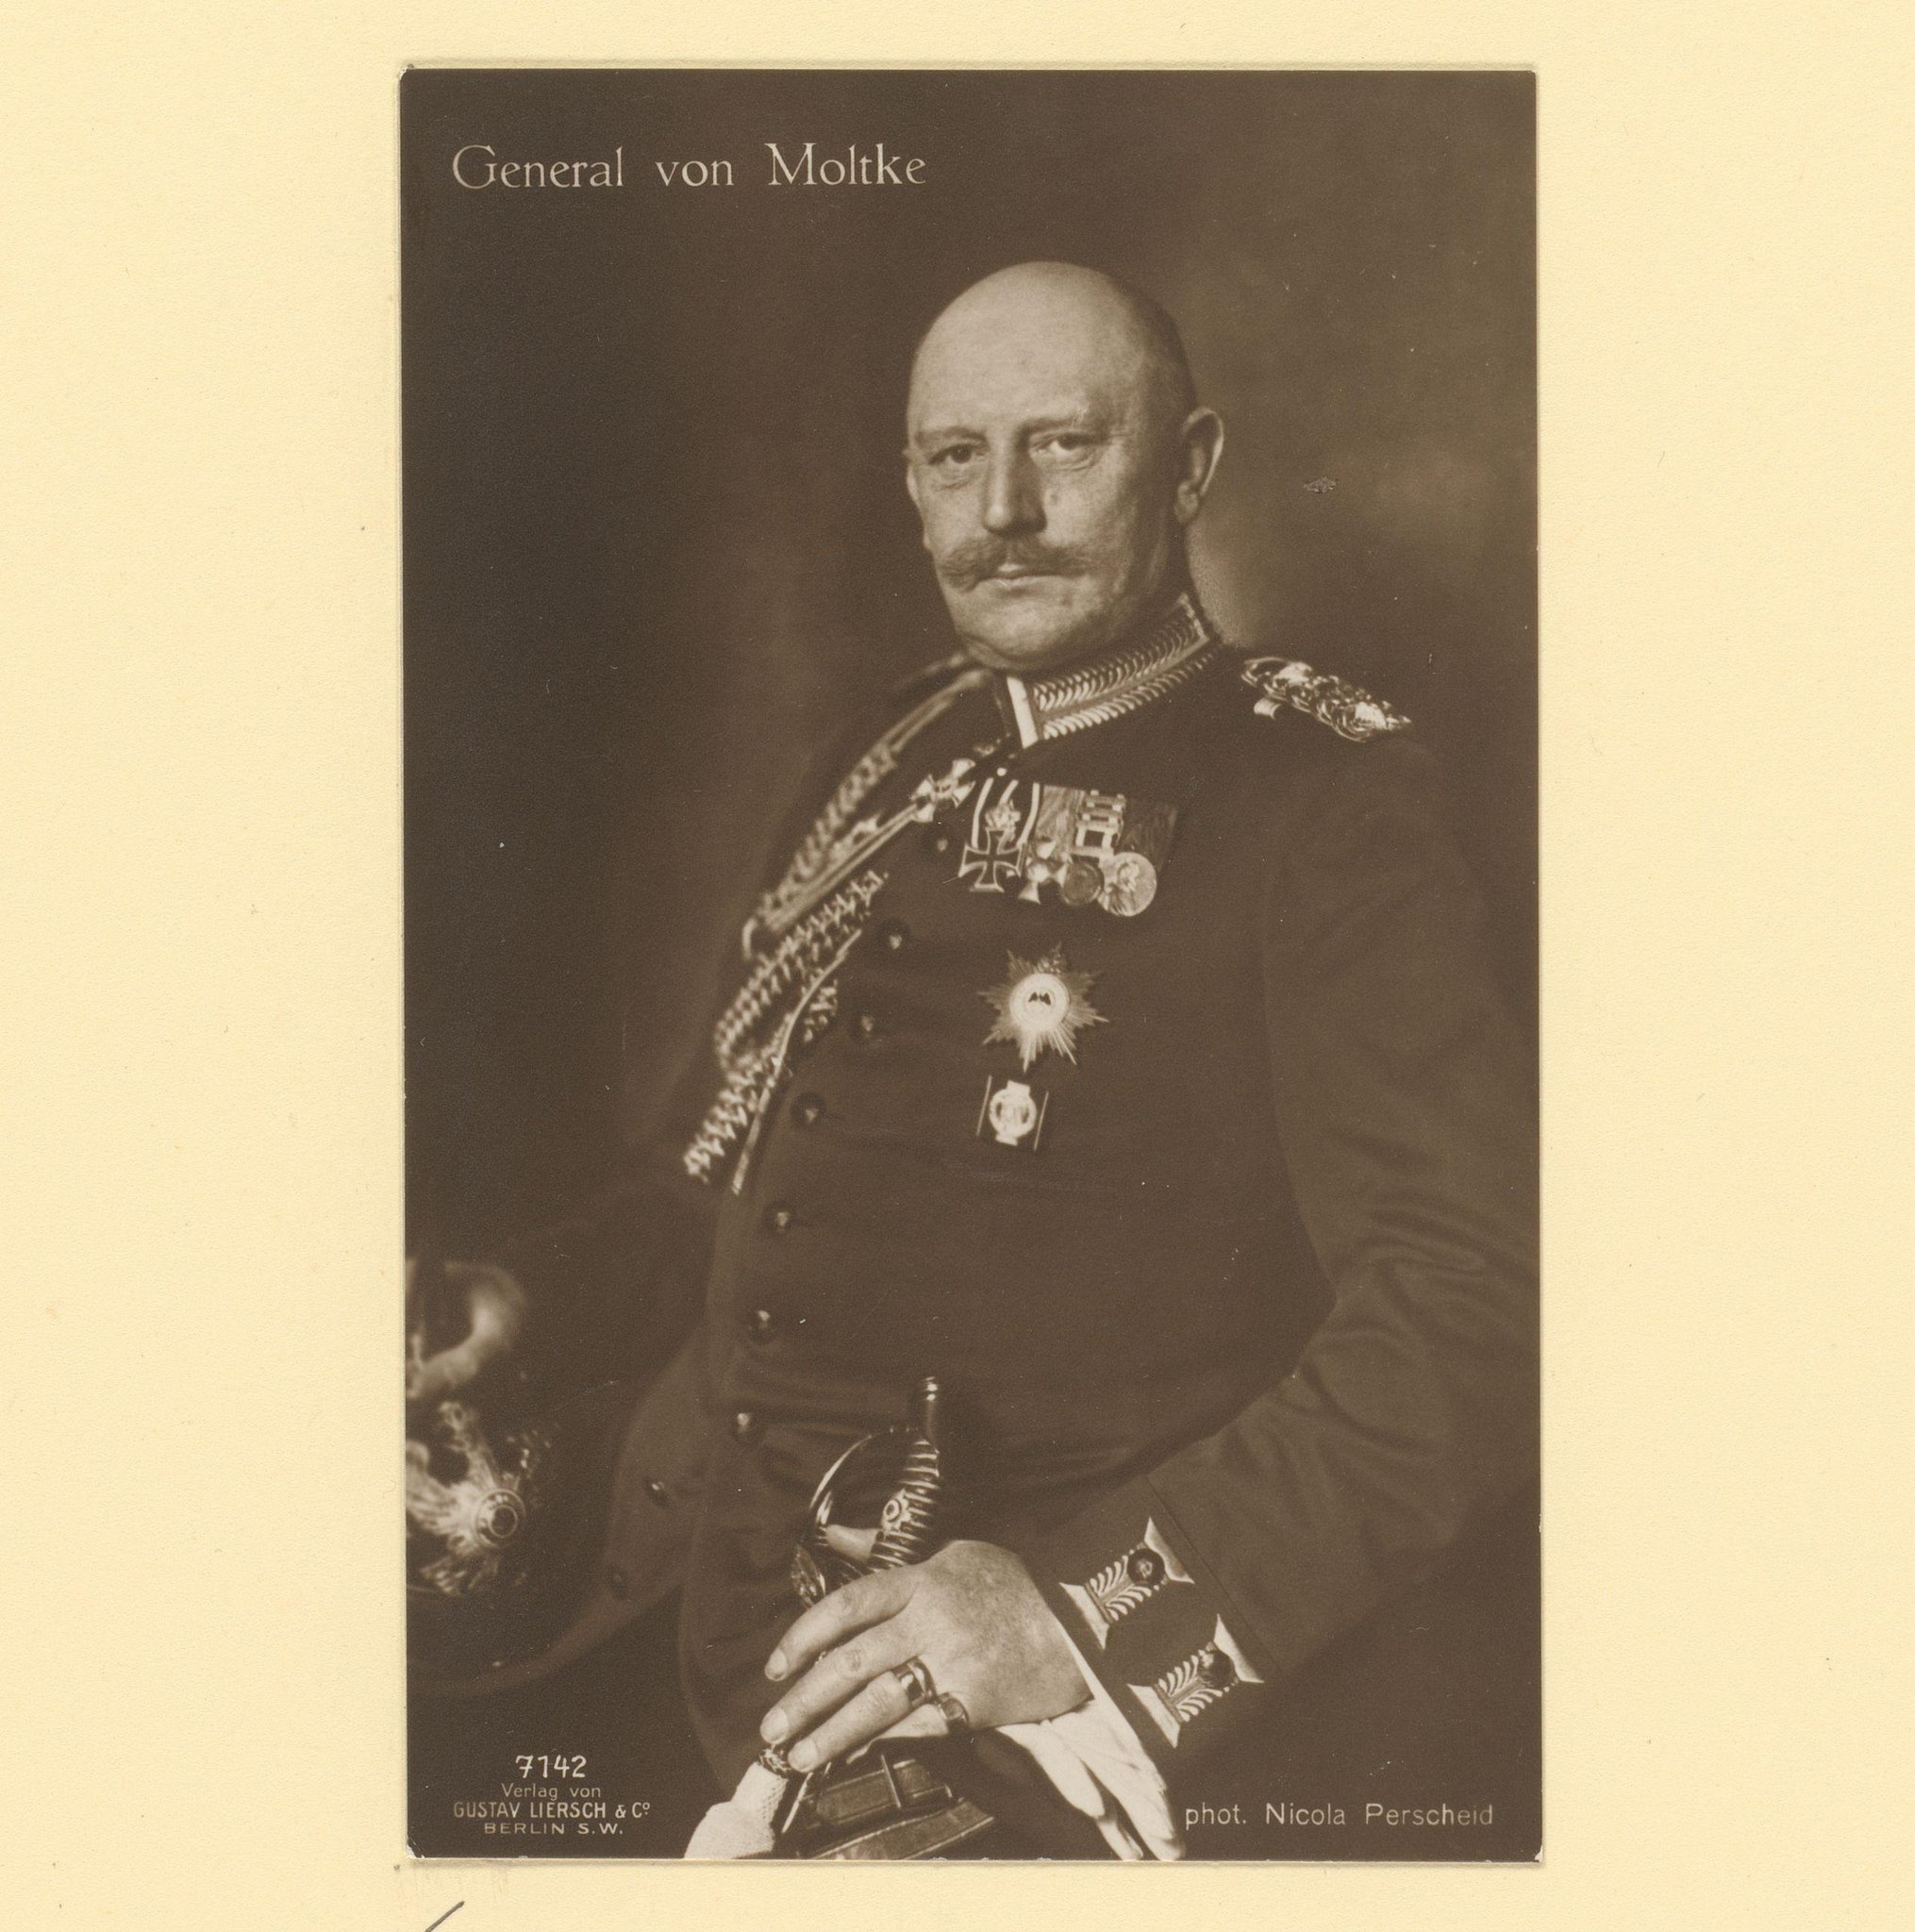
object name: ansichtkaart, prentbriefkaart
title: General von Moltke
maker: nicola perscheid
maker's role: fotograaf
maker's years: 1864-1930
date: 1905-1910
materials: paper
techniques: gelatin silver print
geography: berlin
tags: berlin, commander-in-chief, general, marshal, historical persons, picture, painting, (military) uniforms